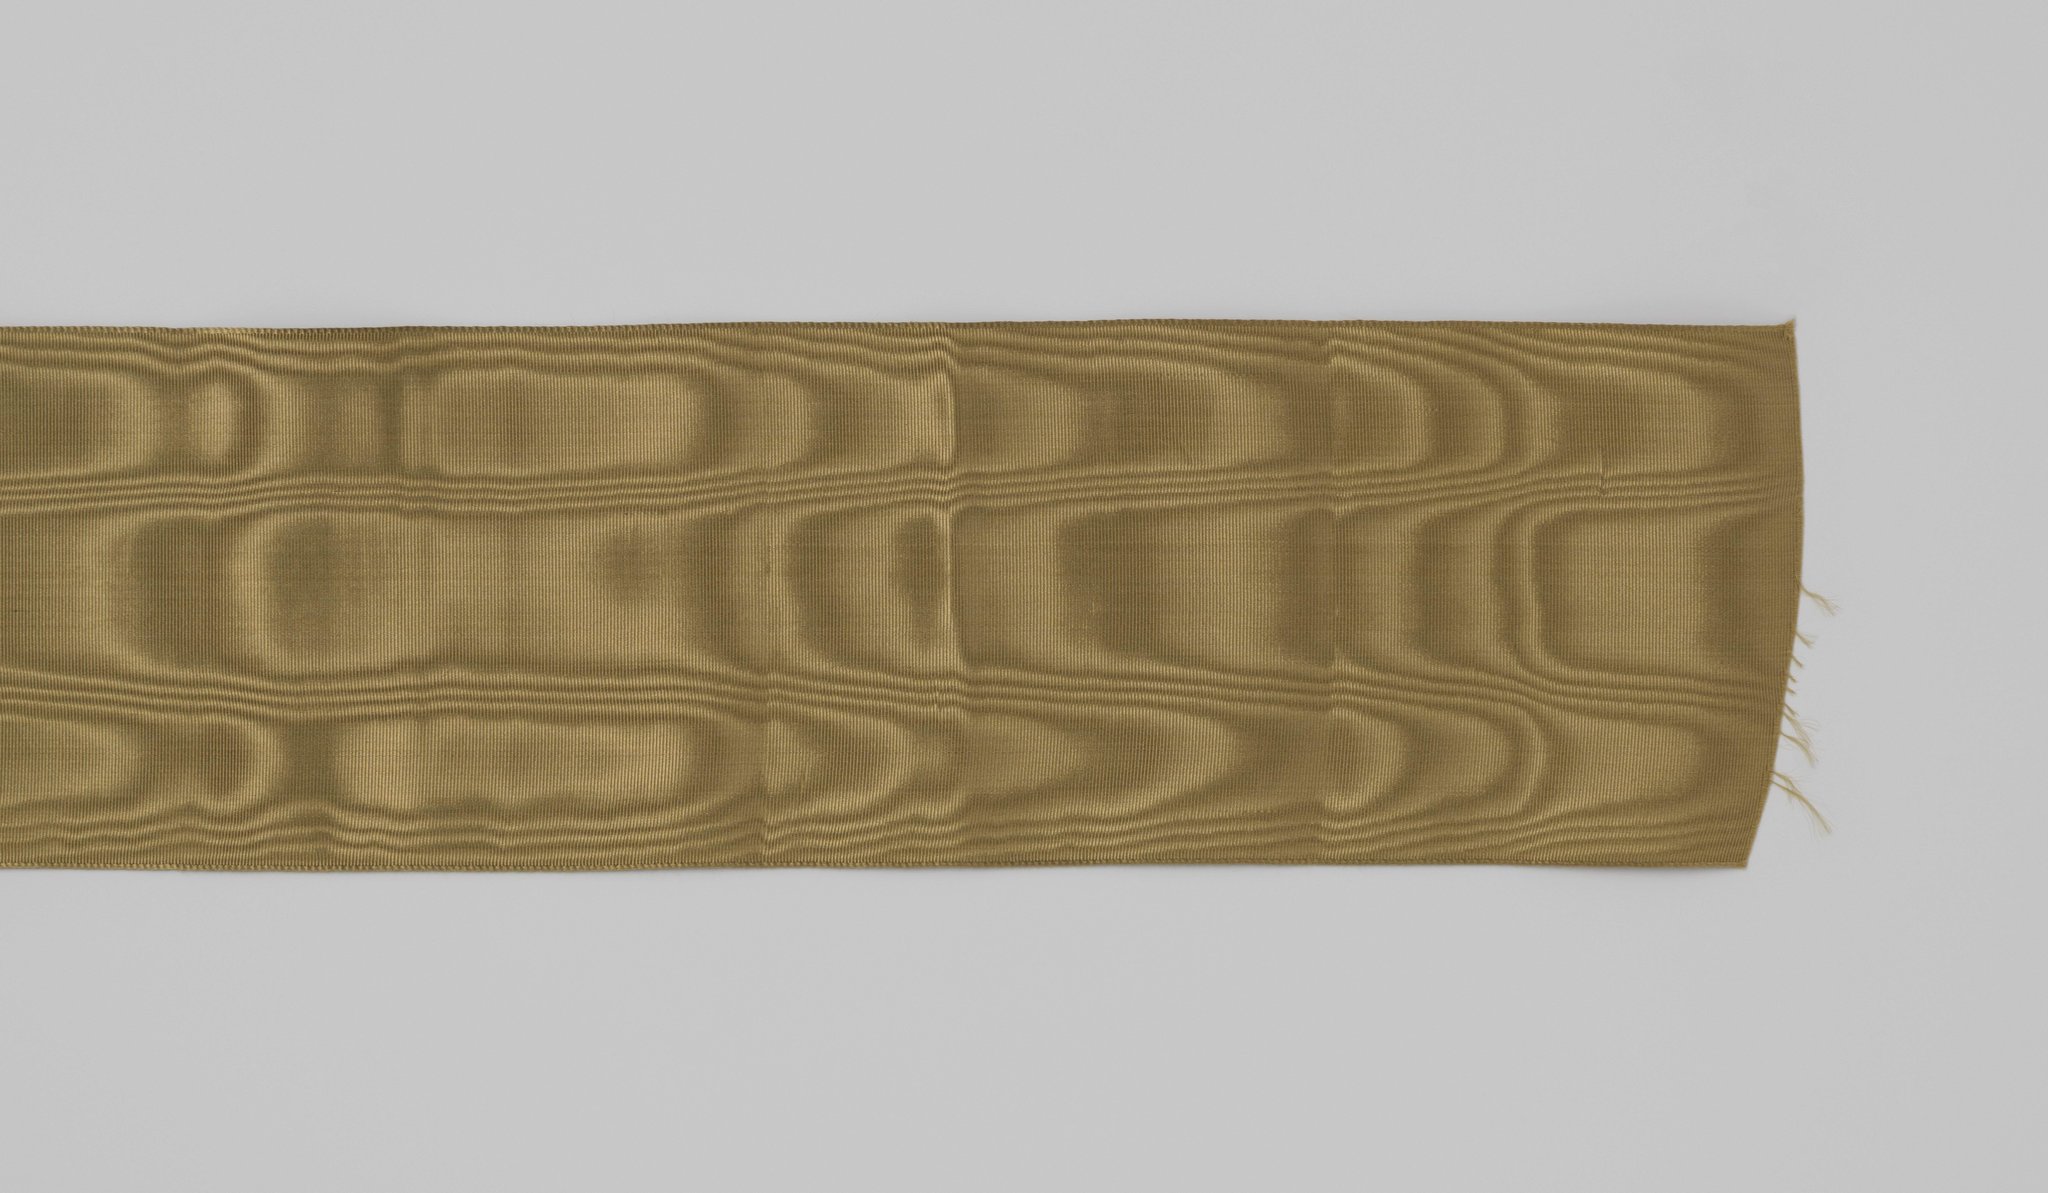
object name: ribbon material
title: Zijden lint, in mosgroen moiré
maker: Anonymous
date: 1900-1950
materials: silk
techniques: moire, weave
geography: western europe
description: Verzameling zijden linten in terra/wit, arise/bruin, champagne, blauw-wit gestreept, mosgroen, marine, paars en zwart.